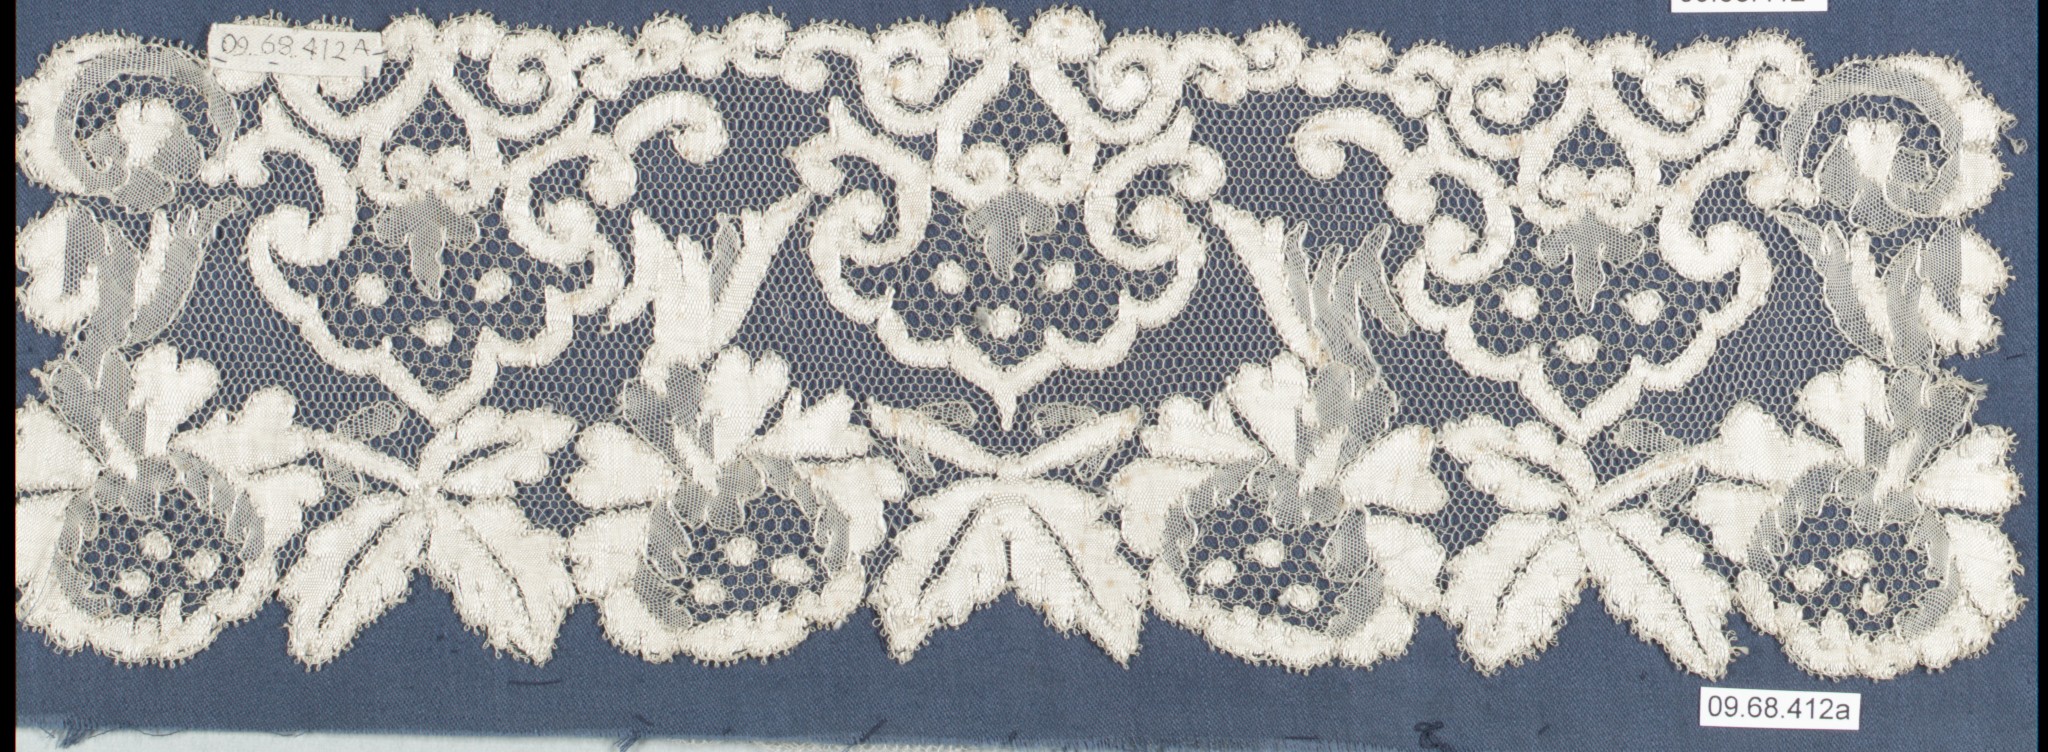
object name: bobbin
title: Silk bobbin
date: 1801-1900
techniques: lace